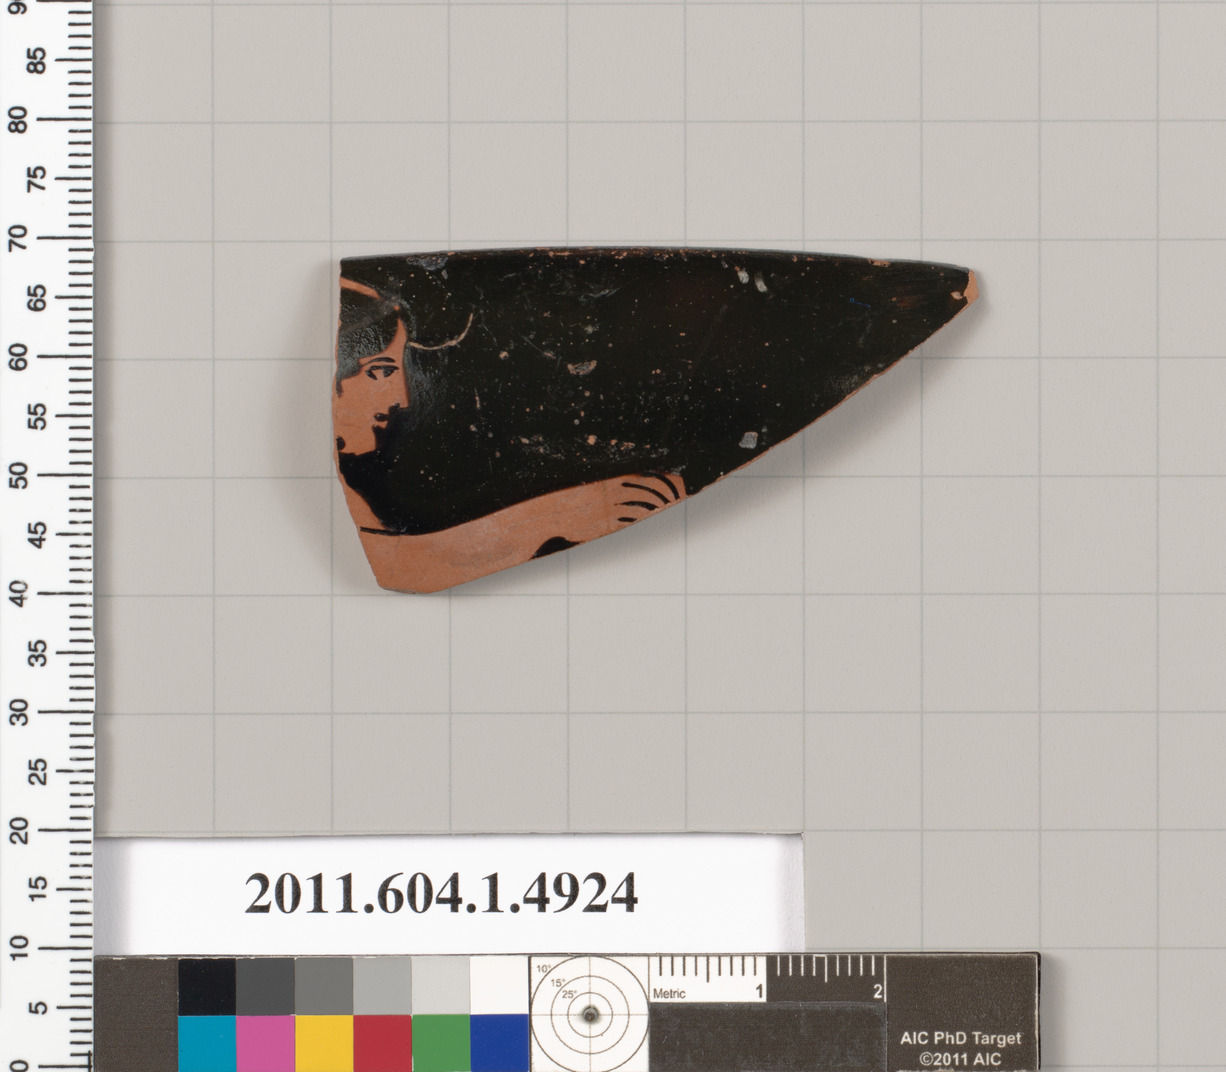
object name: kylix fragment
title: Terracotta rim fragment of a kylix (drinking cup)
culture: greek, attic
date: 467-435 BCE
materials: terracotta